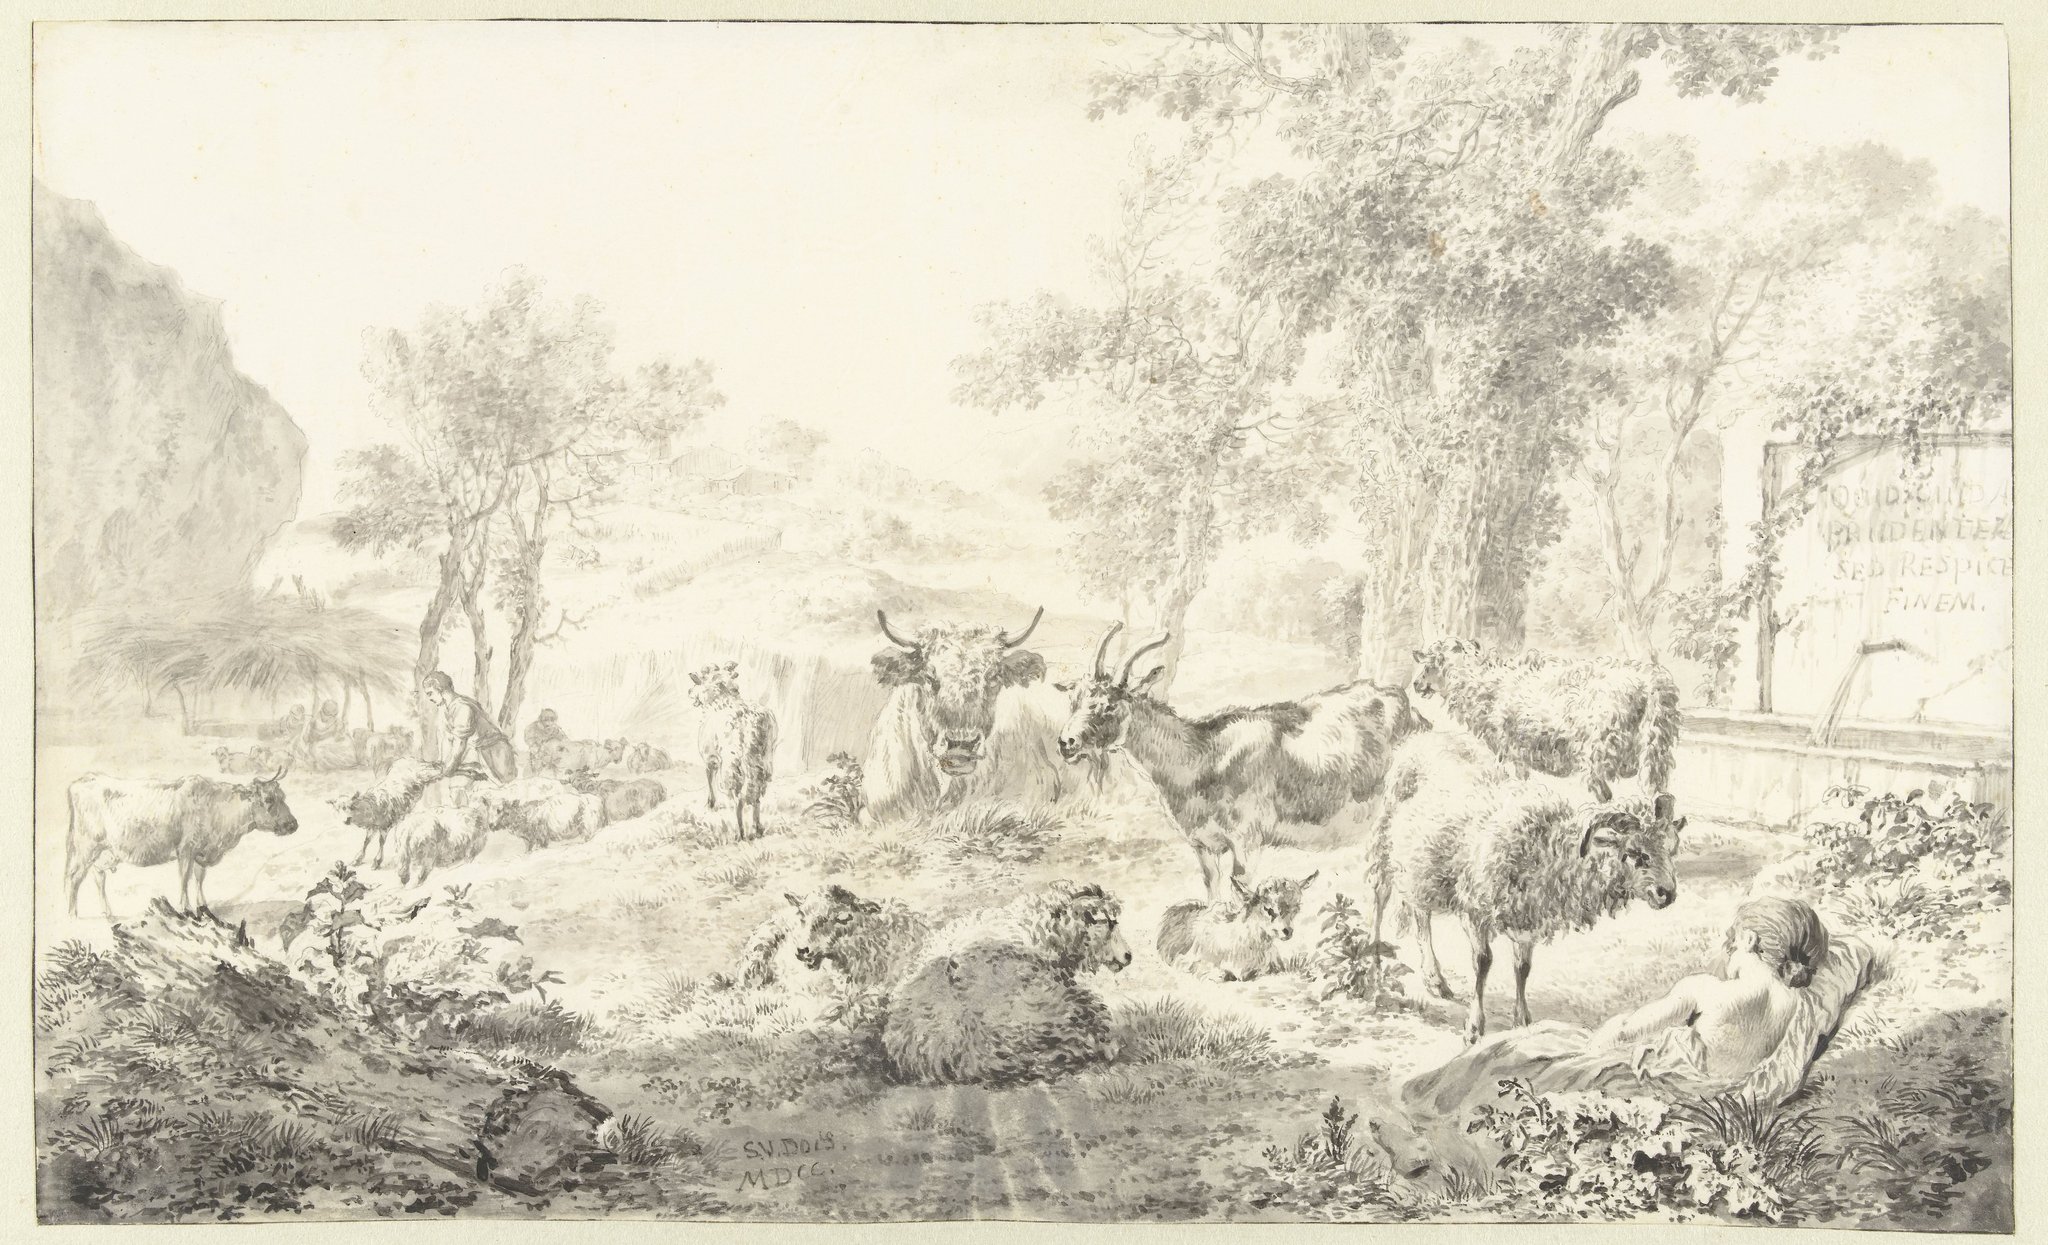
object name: drawing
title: Reclining Shepherdess with a Flock of Sheep and Goats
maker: simon van der does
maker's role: draughtsman, painter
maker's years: 1653-1763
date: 1700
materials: graphite, ink, parchment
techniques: brush